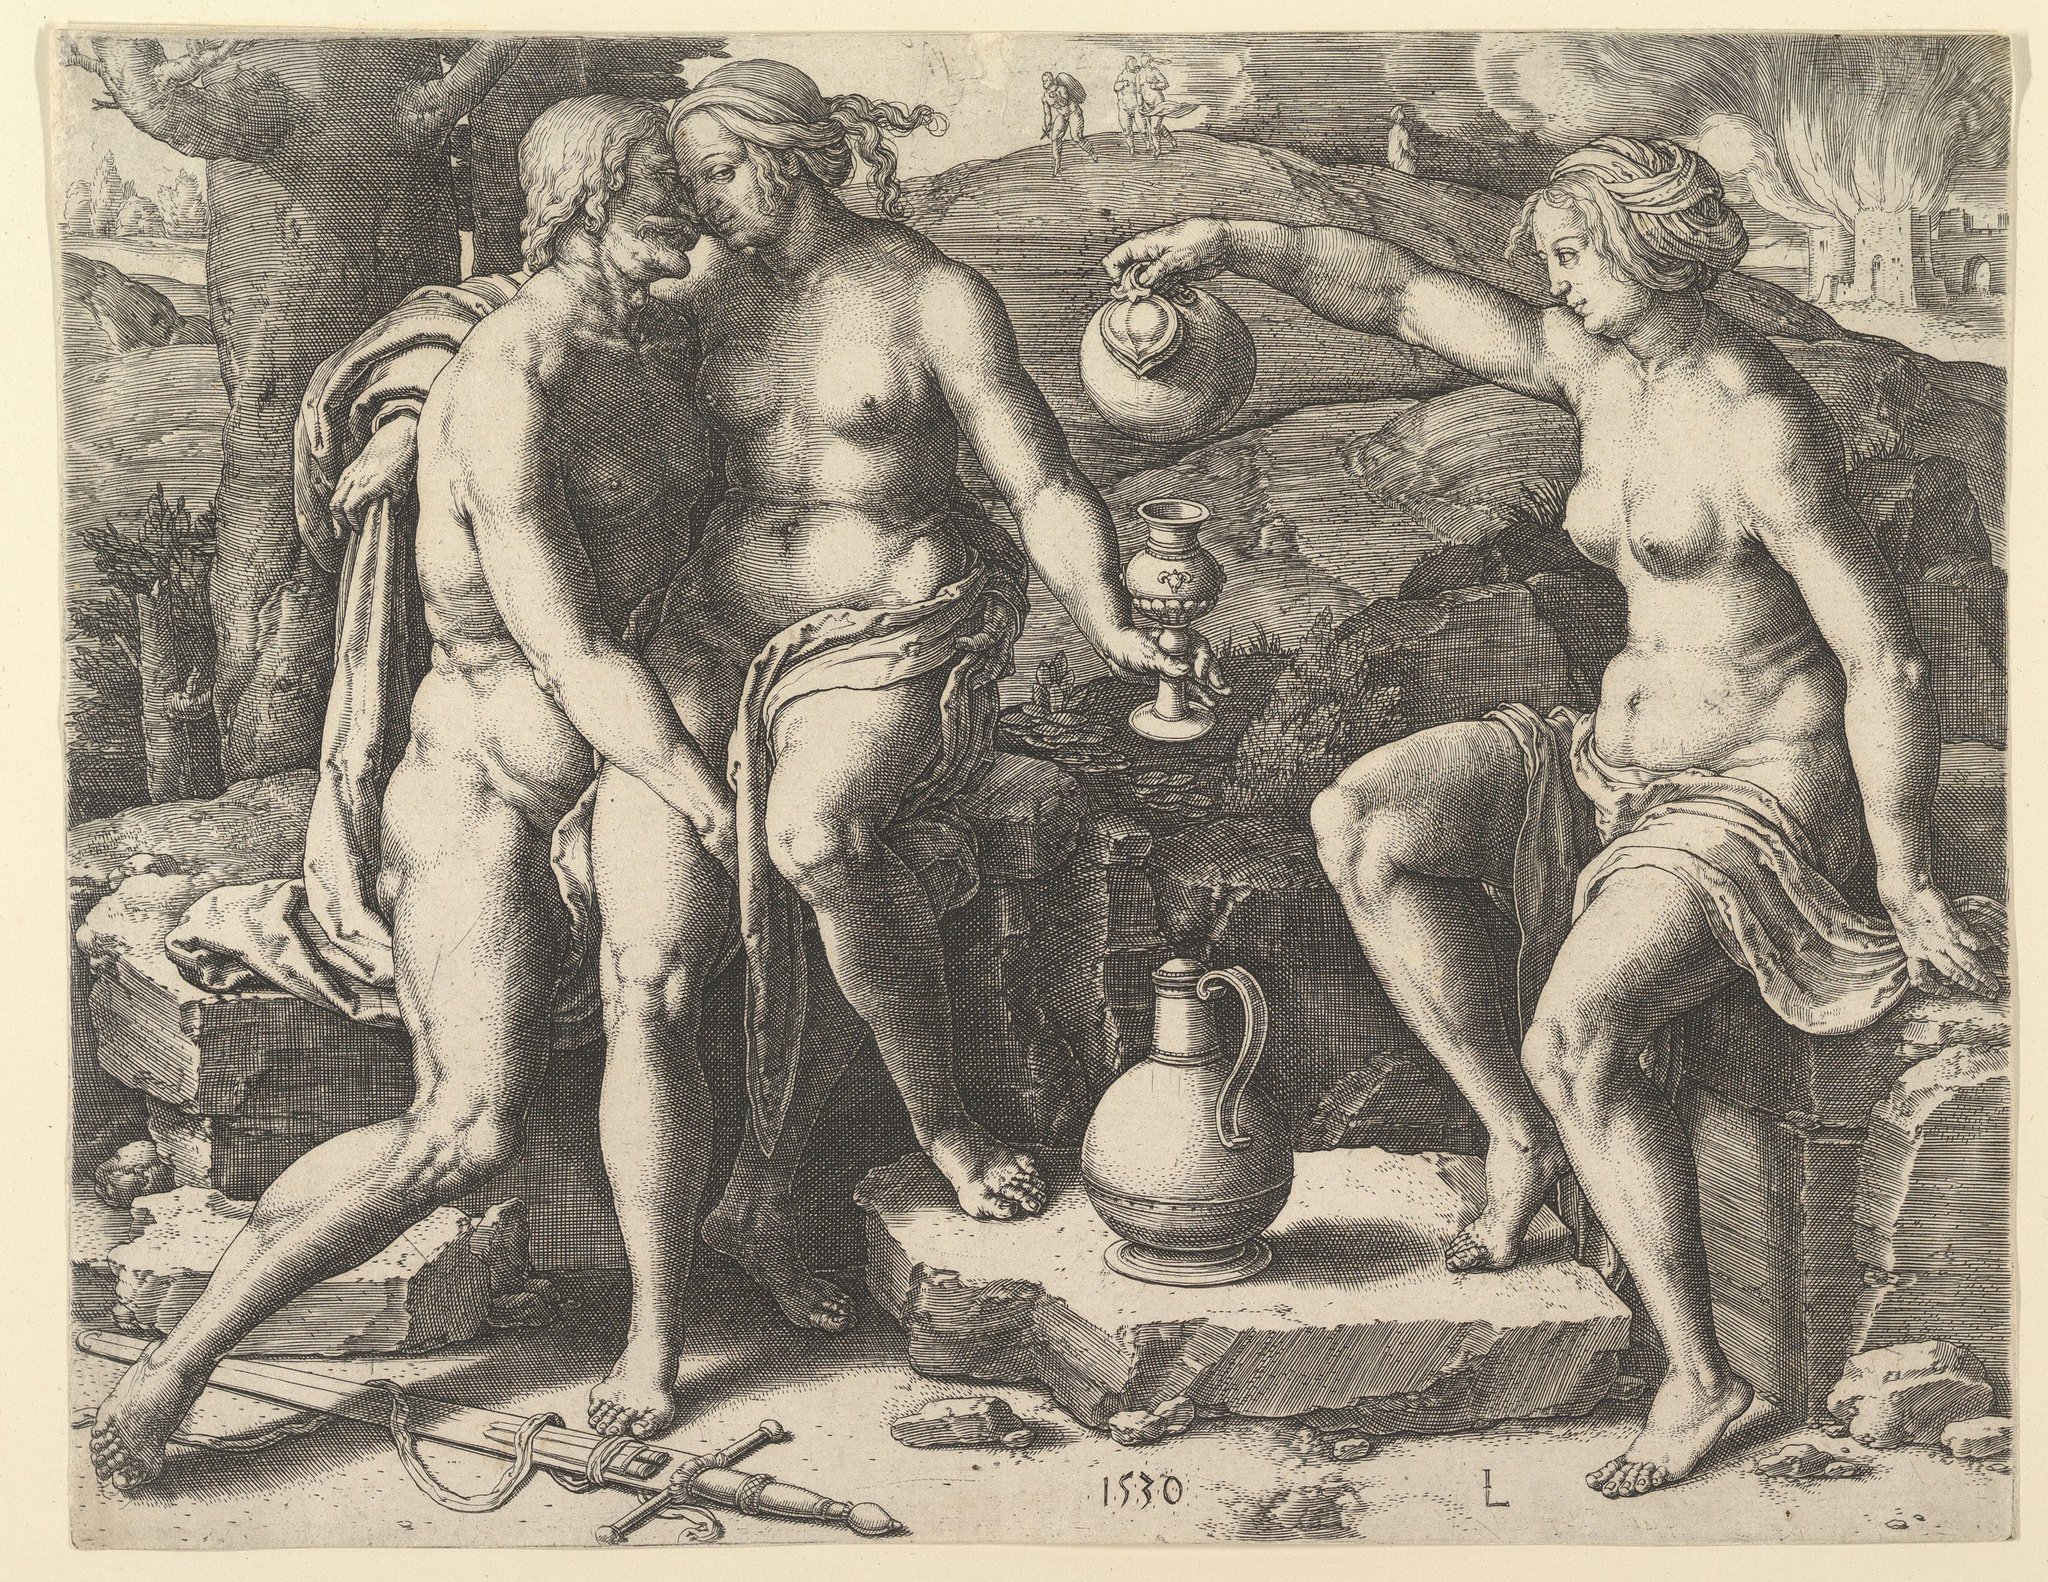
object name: print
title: Lot and His Daughters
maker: lucas van leyden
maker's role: artist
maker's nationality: netherlandish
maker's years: 1494-1533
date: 1530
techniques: engraving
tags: swords,male nudes,female nudes